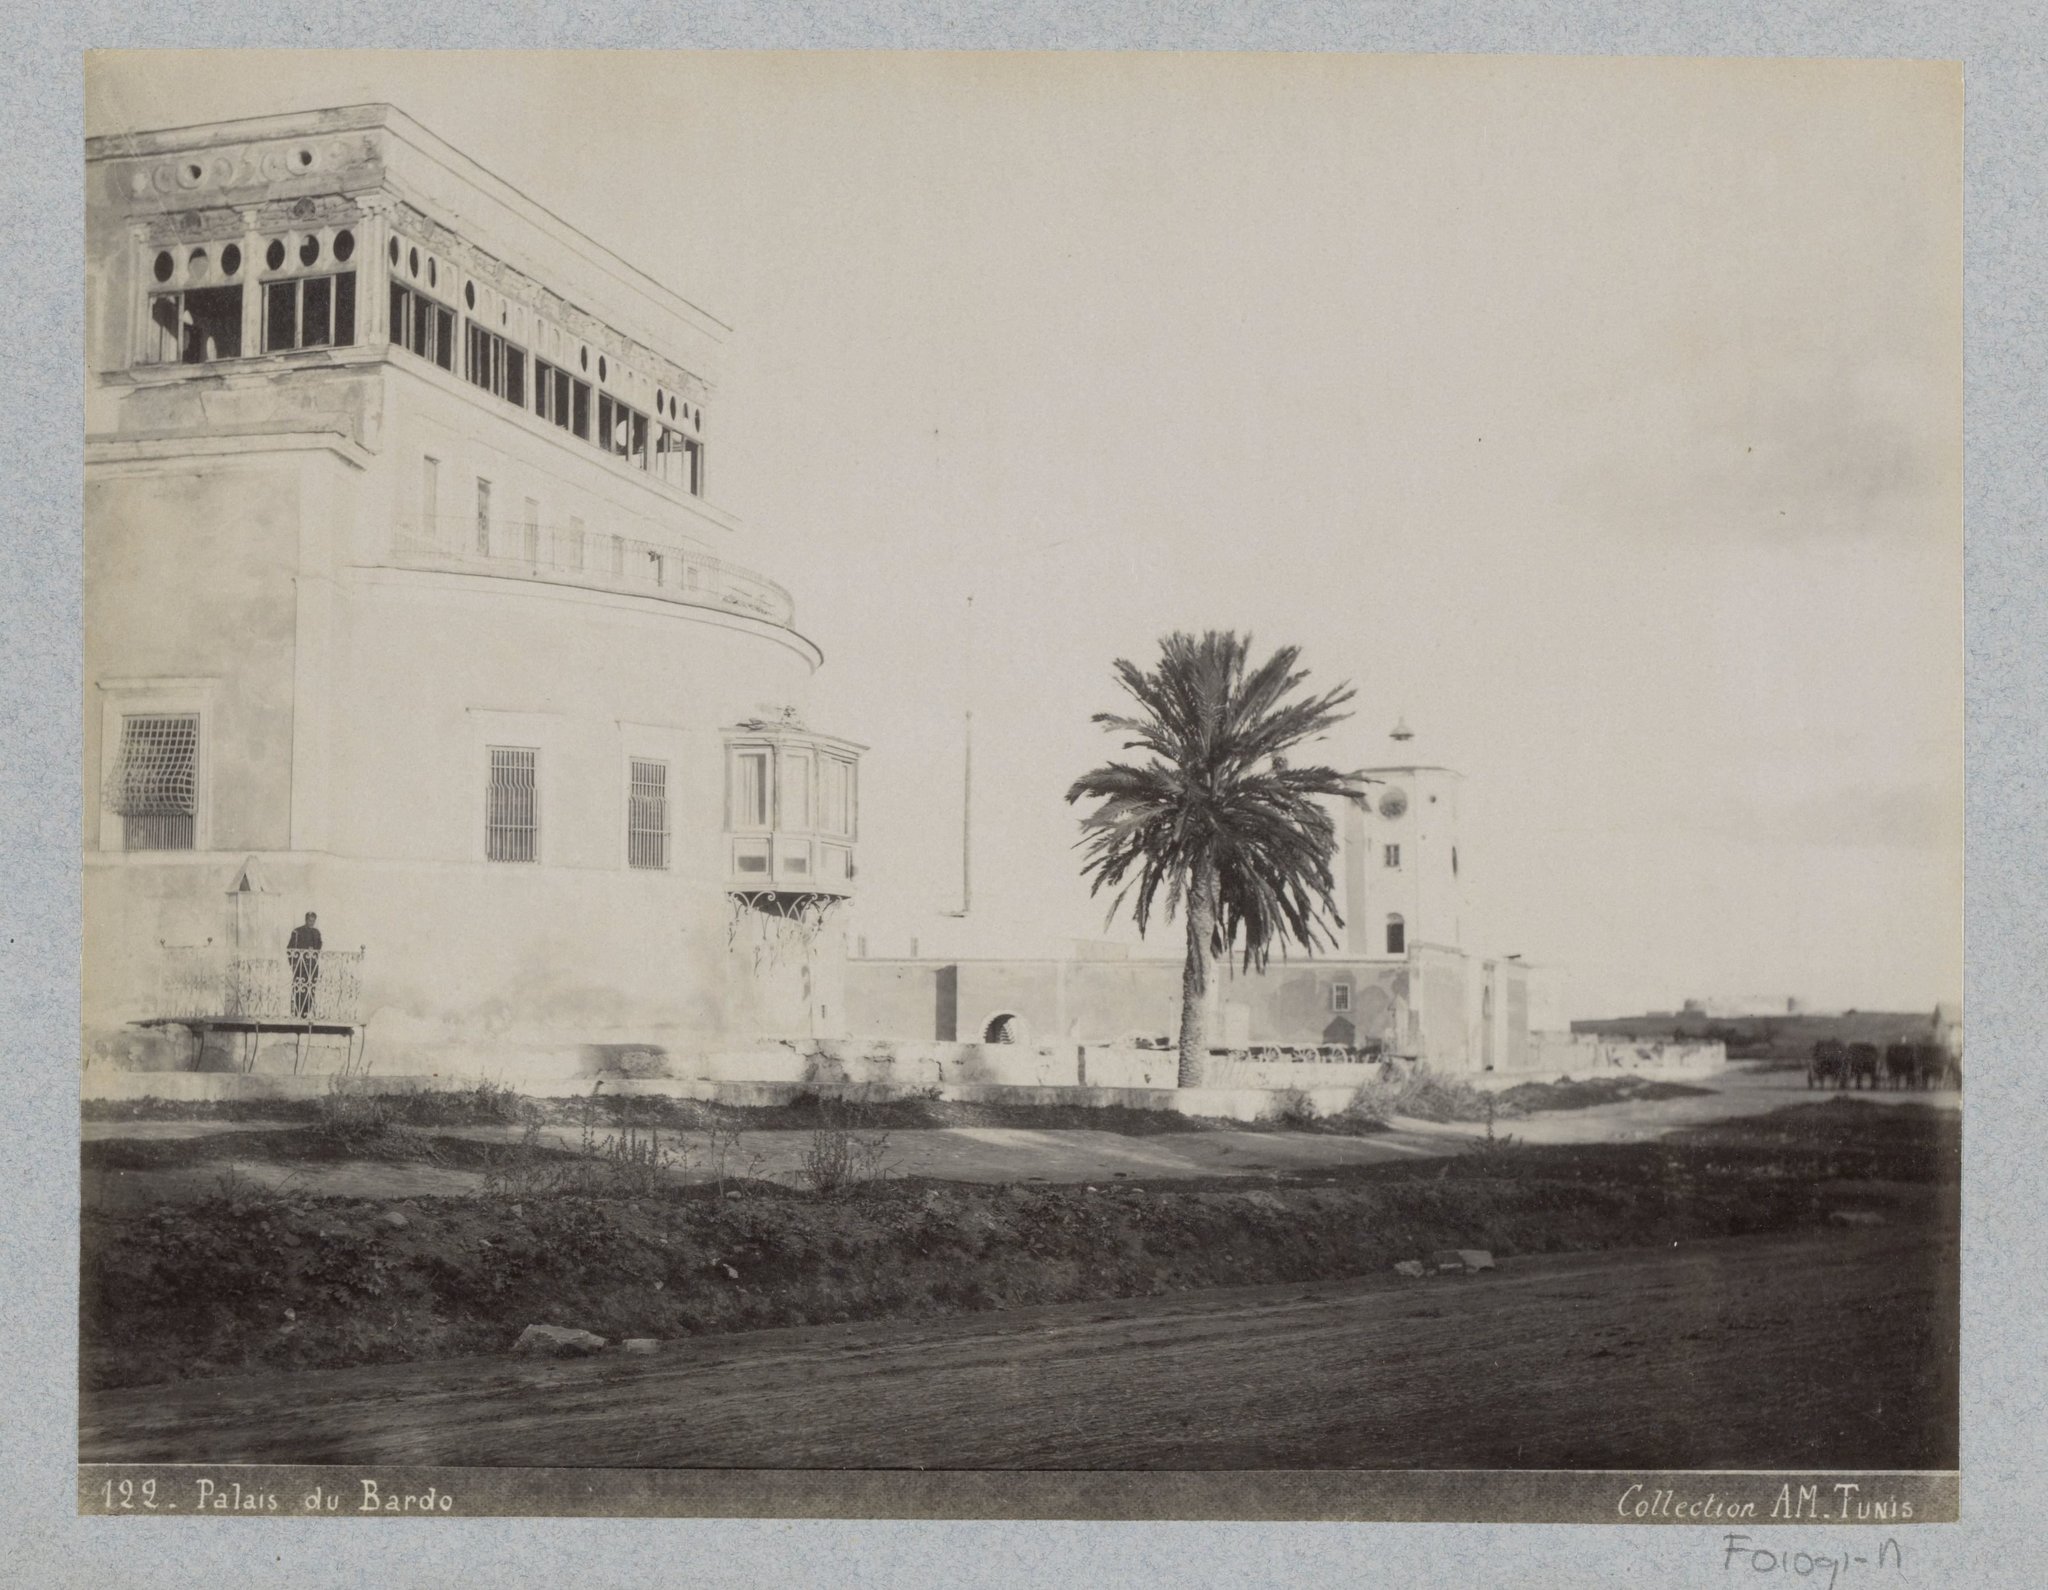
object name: album leaf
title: Exterieur van het Bardopaleis in Tunis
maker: am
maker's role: fotograaf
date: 1880-1900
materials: paper, photographic support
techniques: albumen print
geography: tunis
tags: palace, trees: palm-tree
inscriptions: negative number: ‘122’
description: Onderdeel van Reisalbum met foto's van bezienswaardigheden in Tunis en Tunesië.